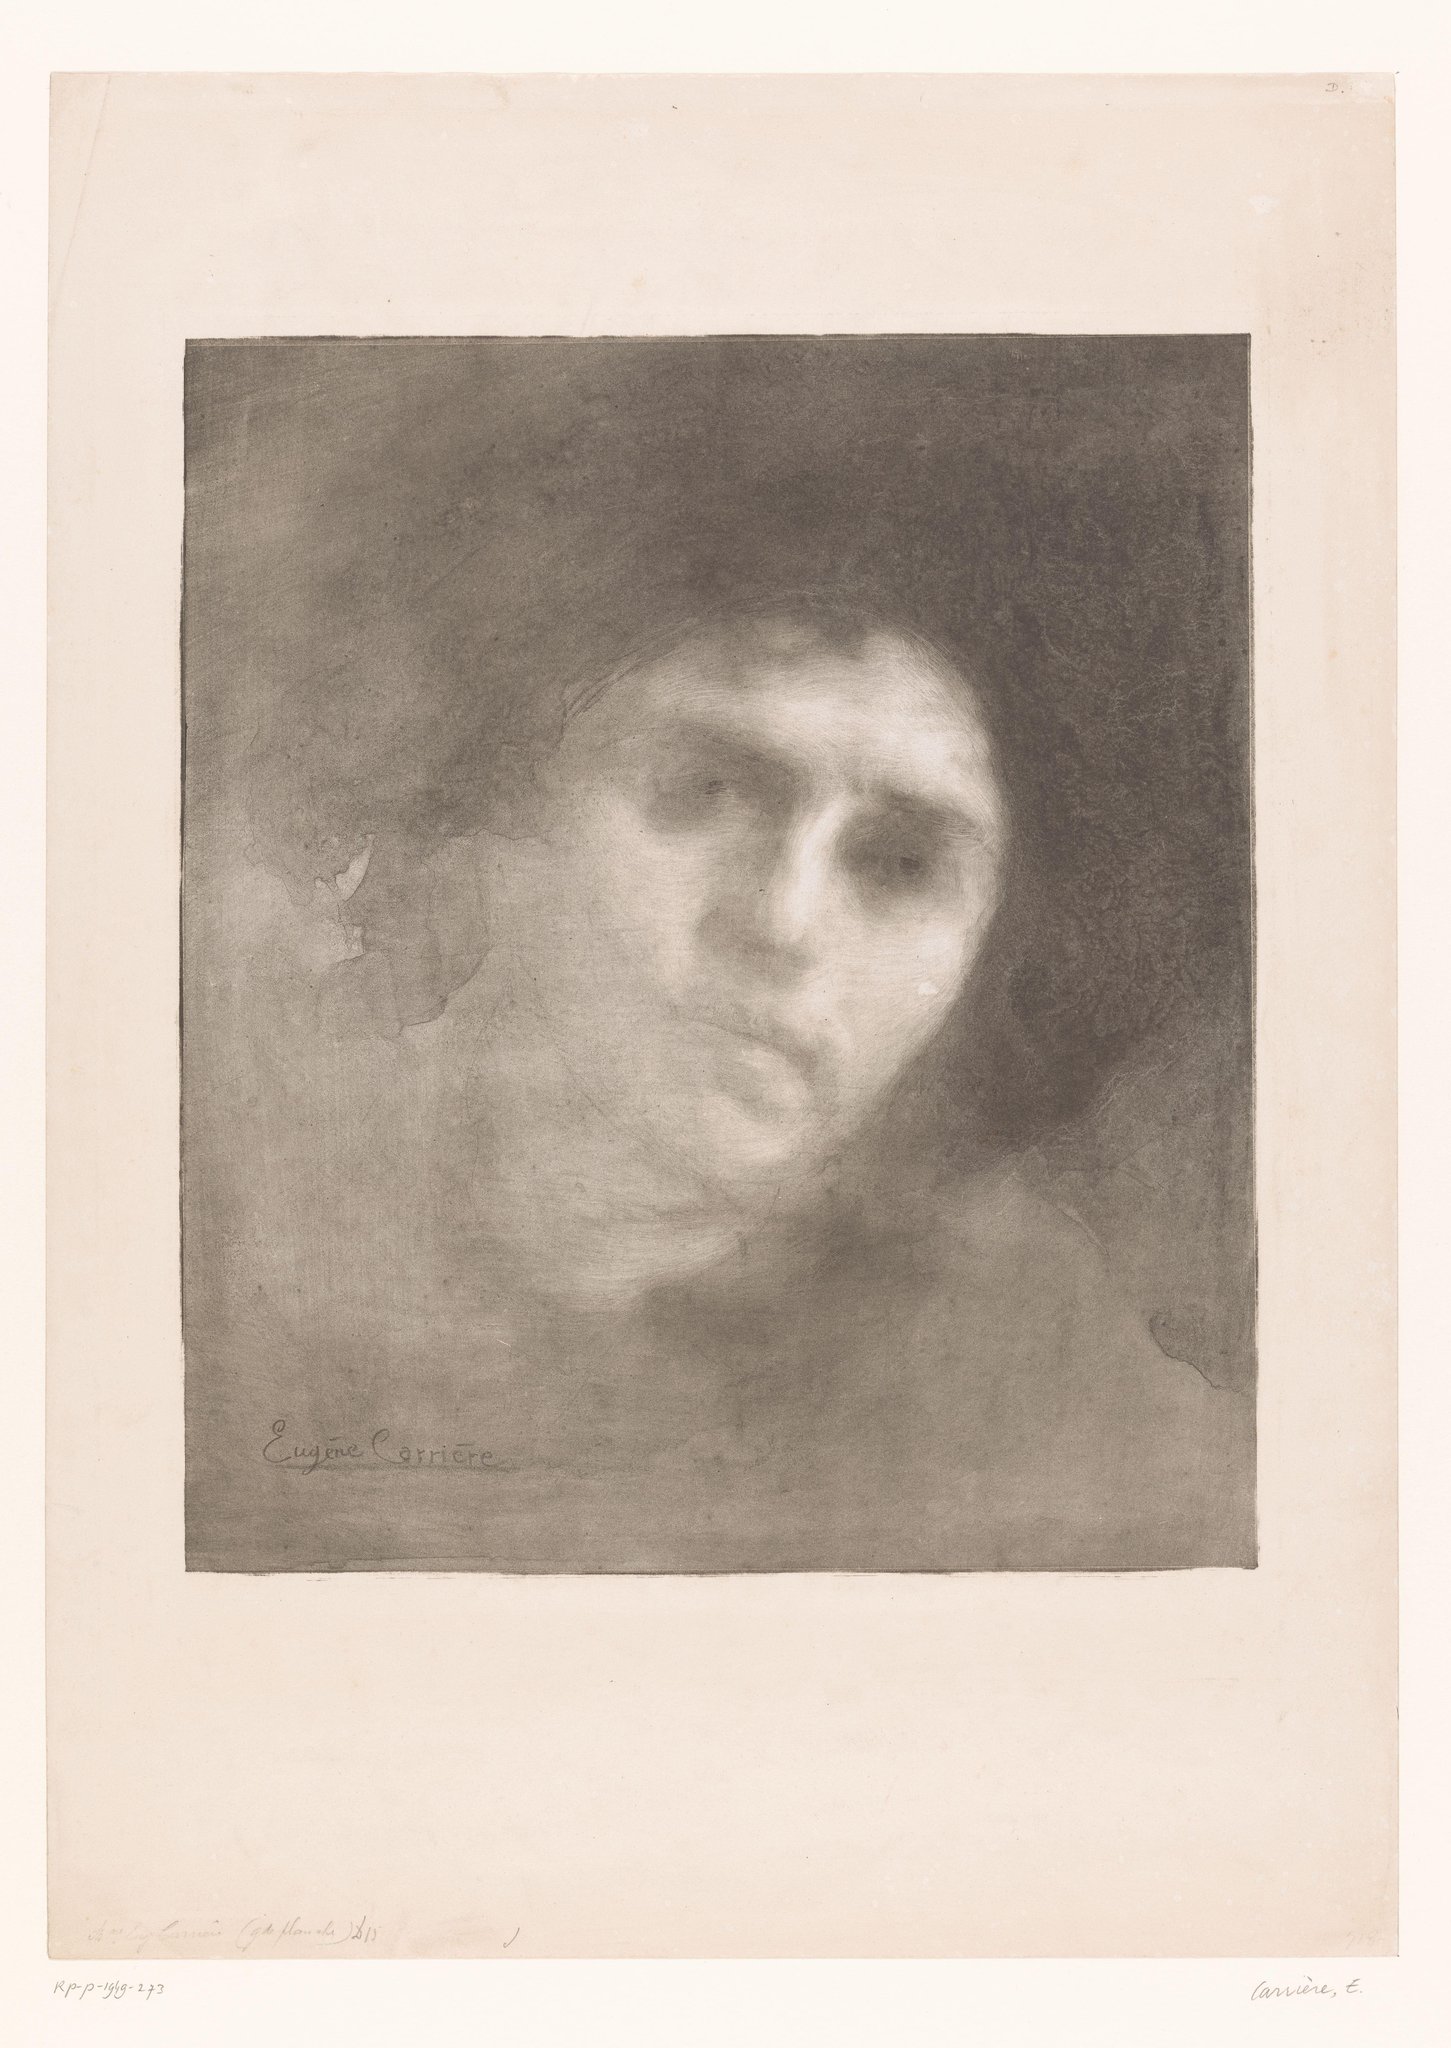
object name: print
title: Mme Eugène Carrière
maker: eugène carrière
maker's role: draughtsman, print maker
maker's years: 1849-1906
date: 1893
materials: paper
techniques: lithograph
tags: paris, historical persons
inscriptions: collector's mark: Lugt 2228a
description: Prent gebruikt voor: L'Estampe Originale, oktober-december 1893.